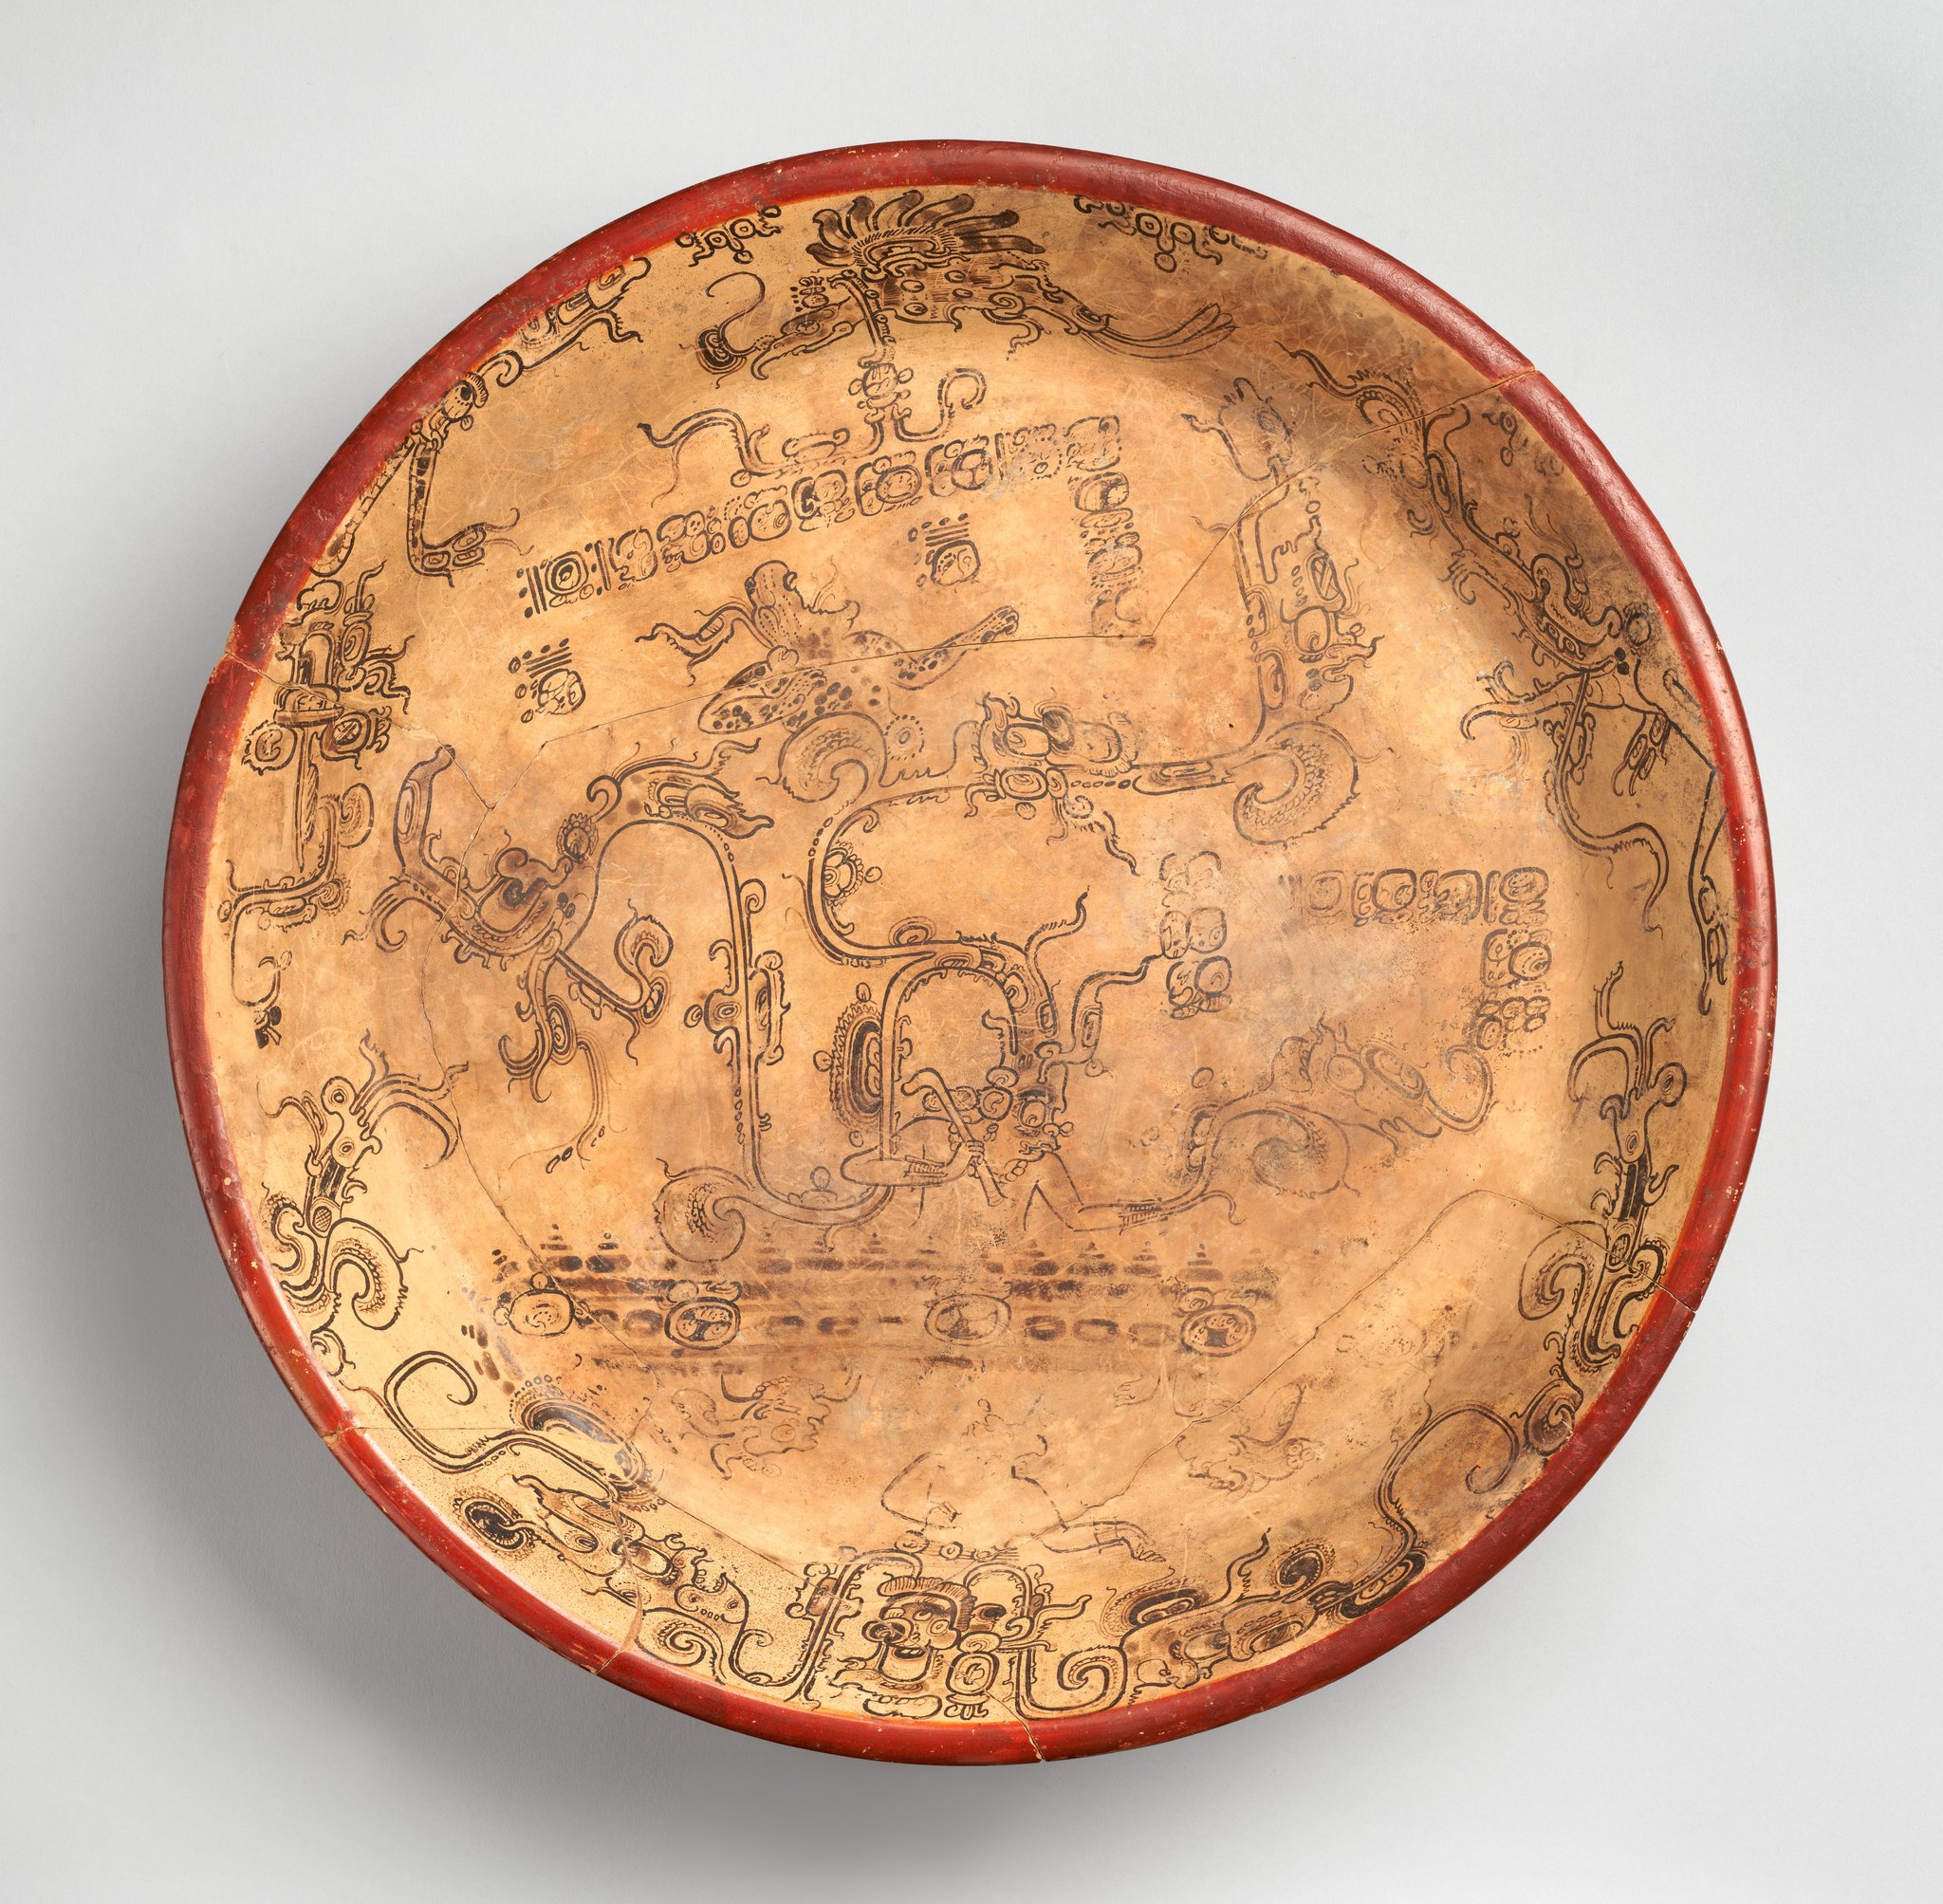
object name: plate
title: Plate with the god Chahk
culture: maya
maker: maya artist(s)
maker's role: artist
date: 600-800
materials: ceramic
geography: guatemala or mexico